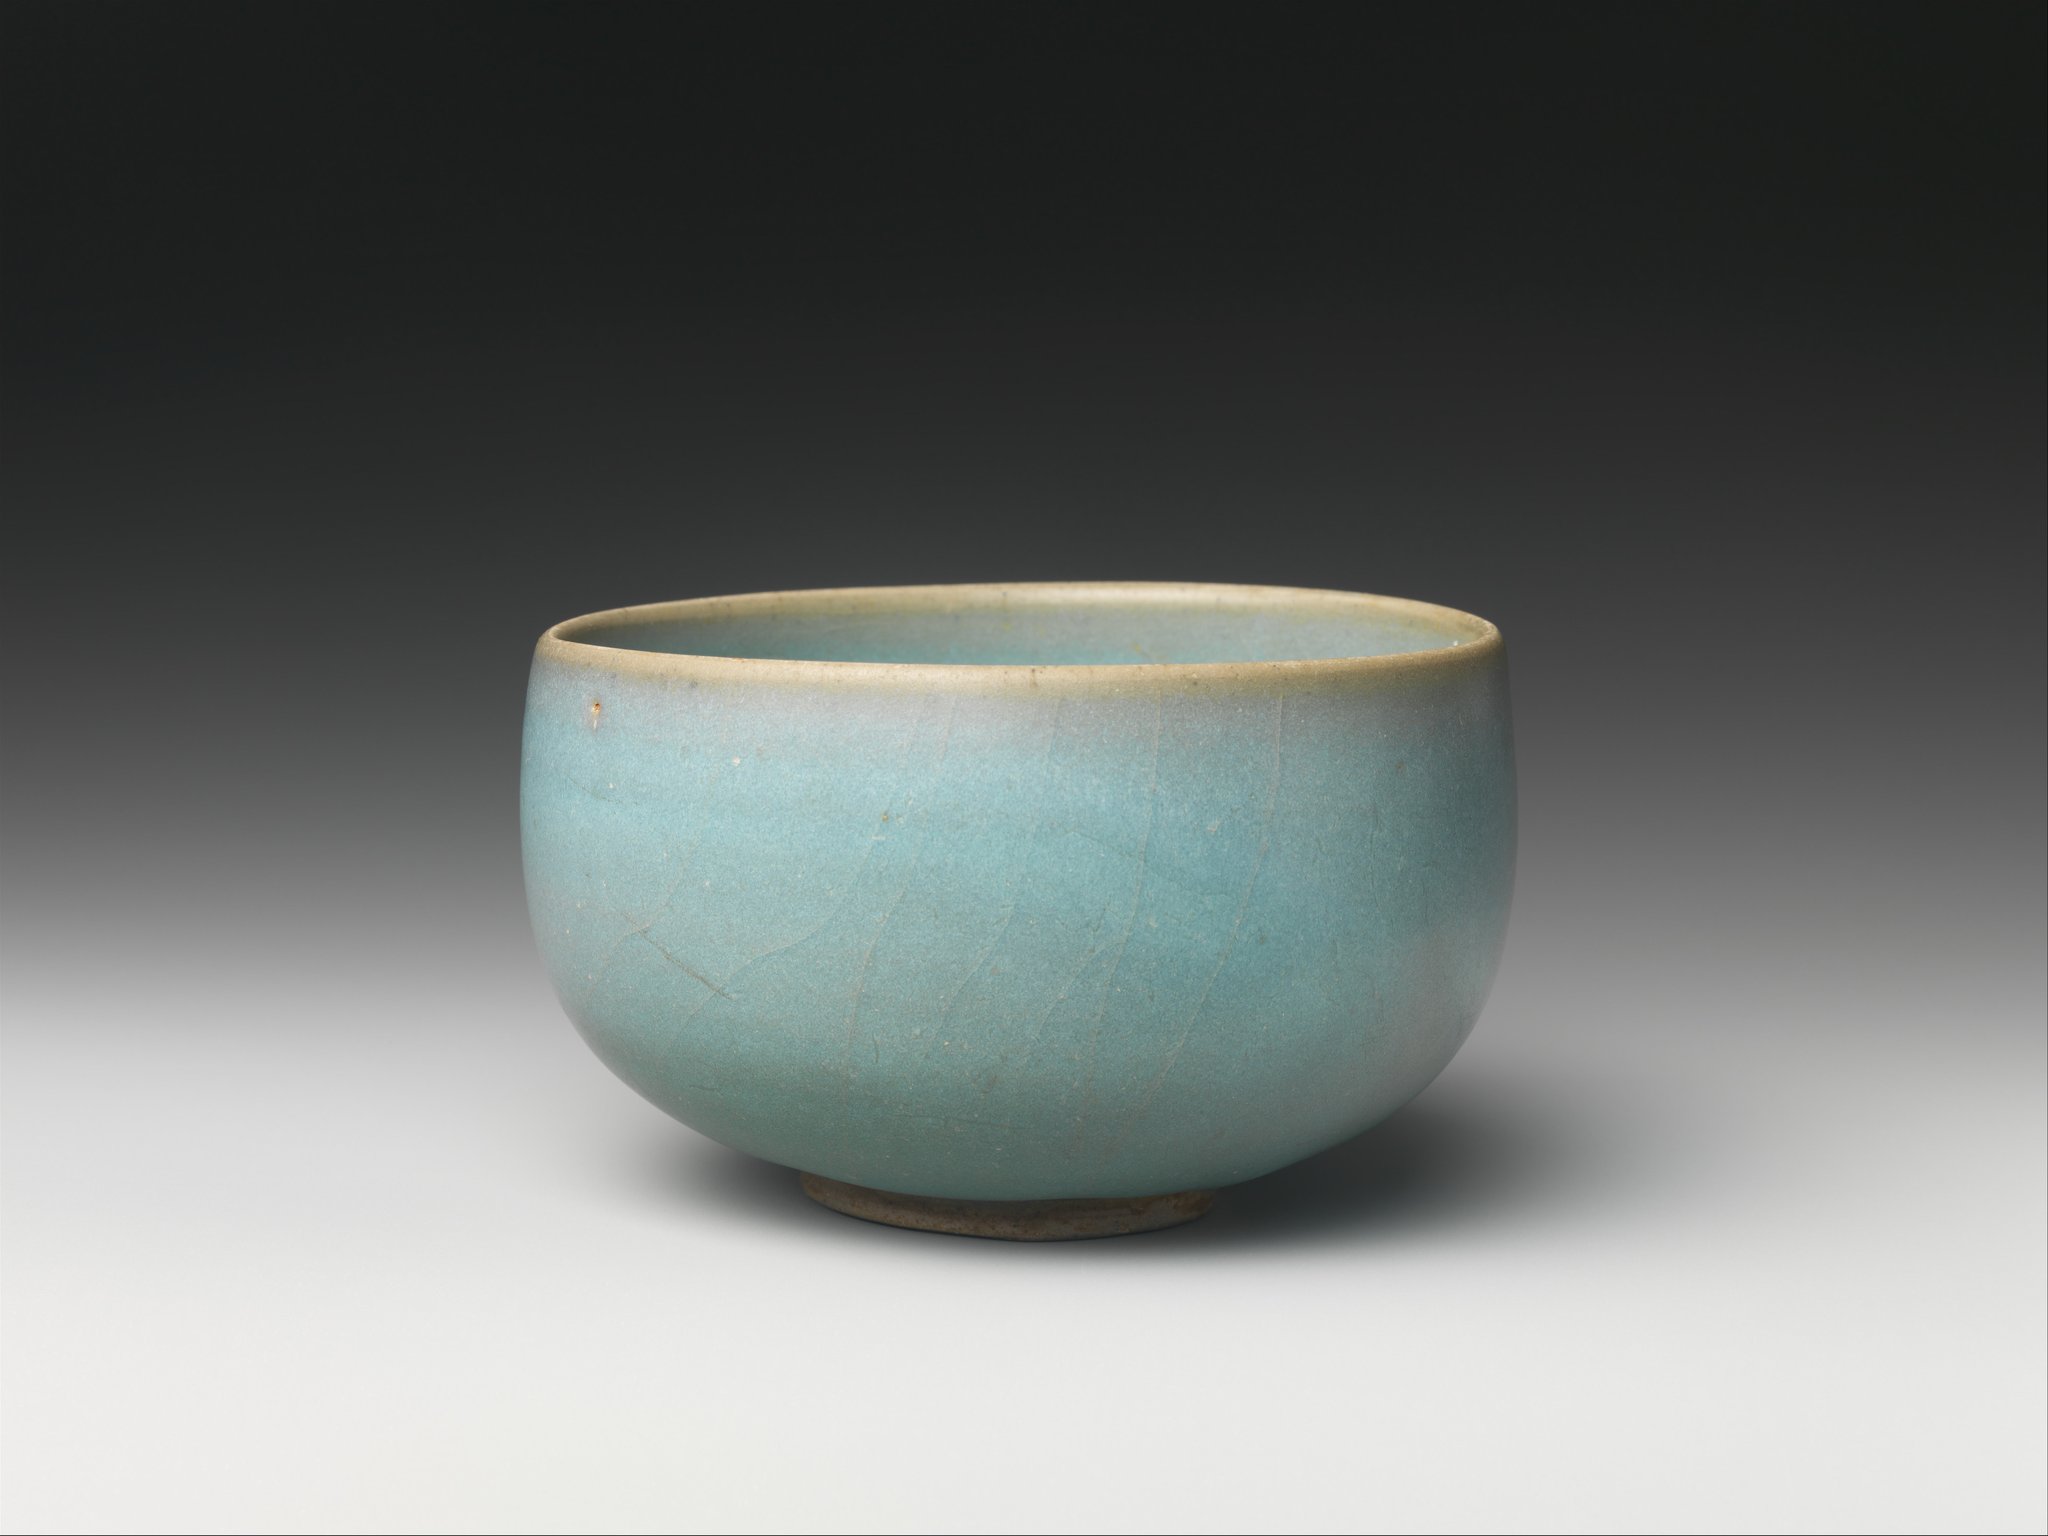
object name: bowl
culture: chinese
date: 1101-1150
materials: glaze, stoneware